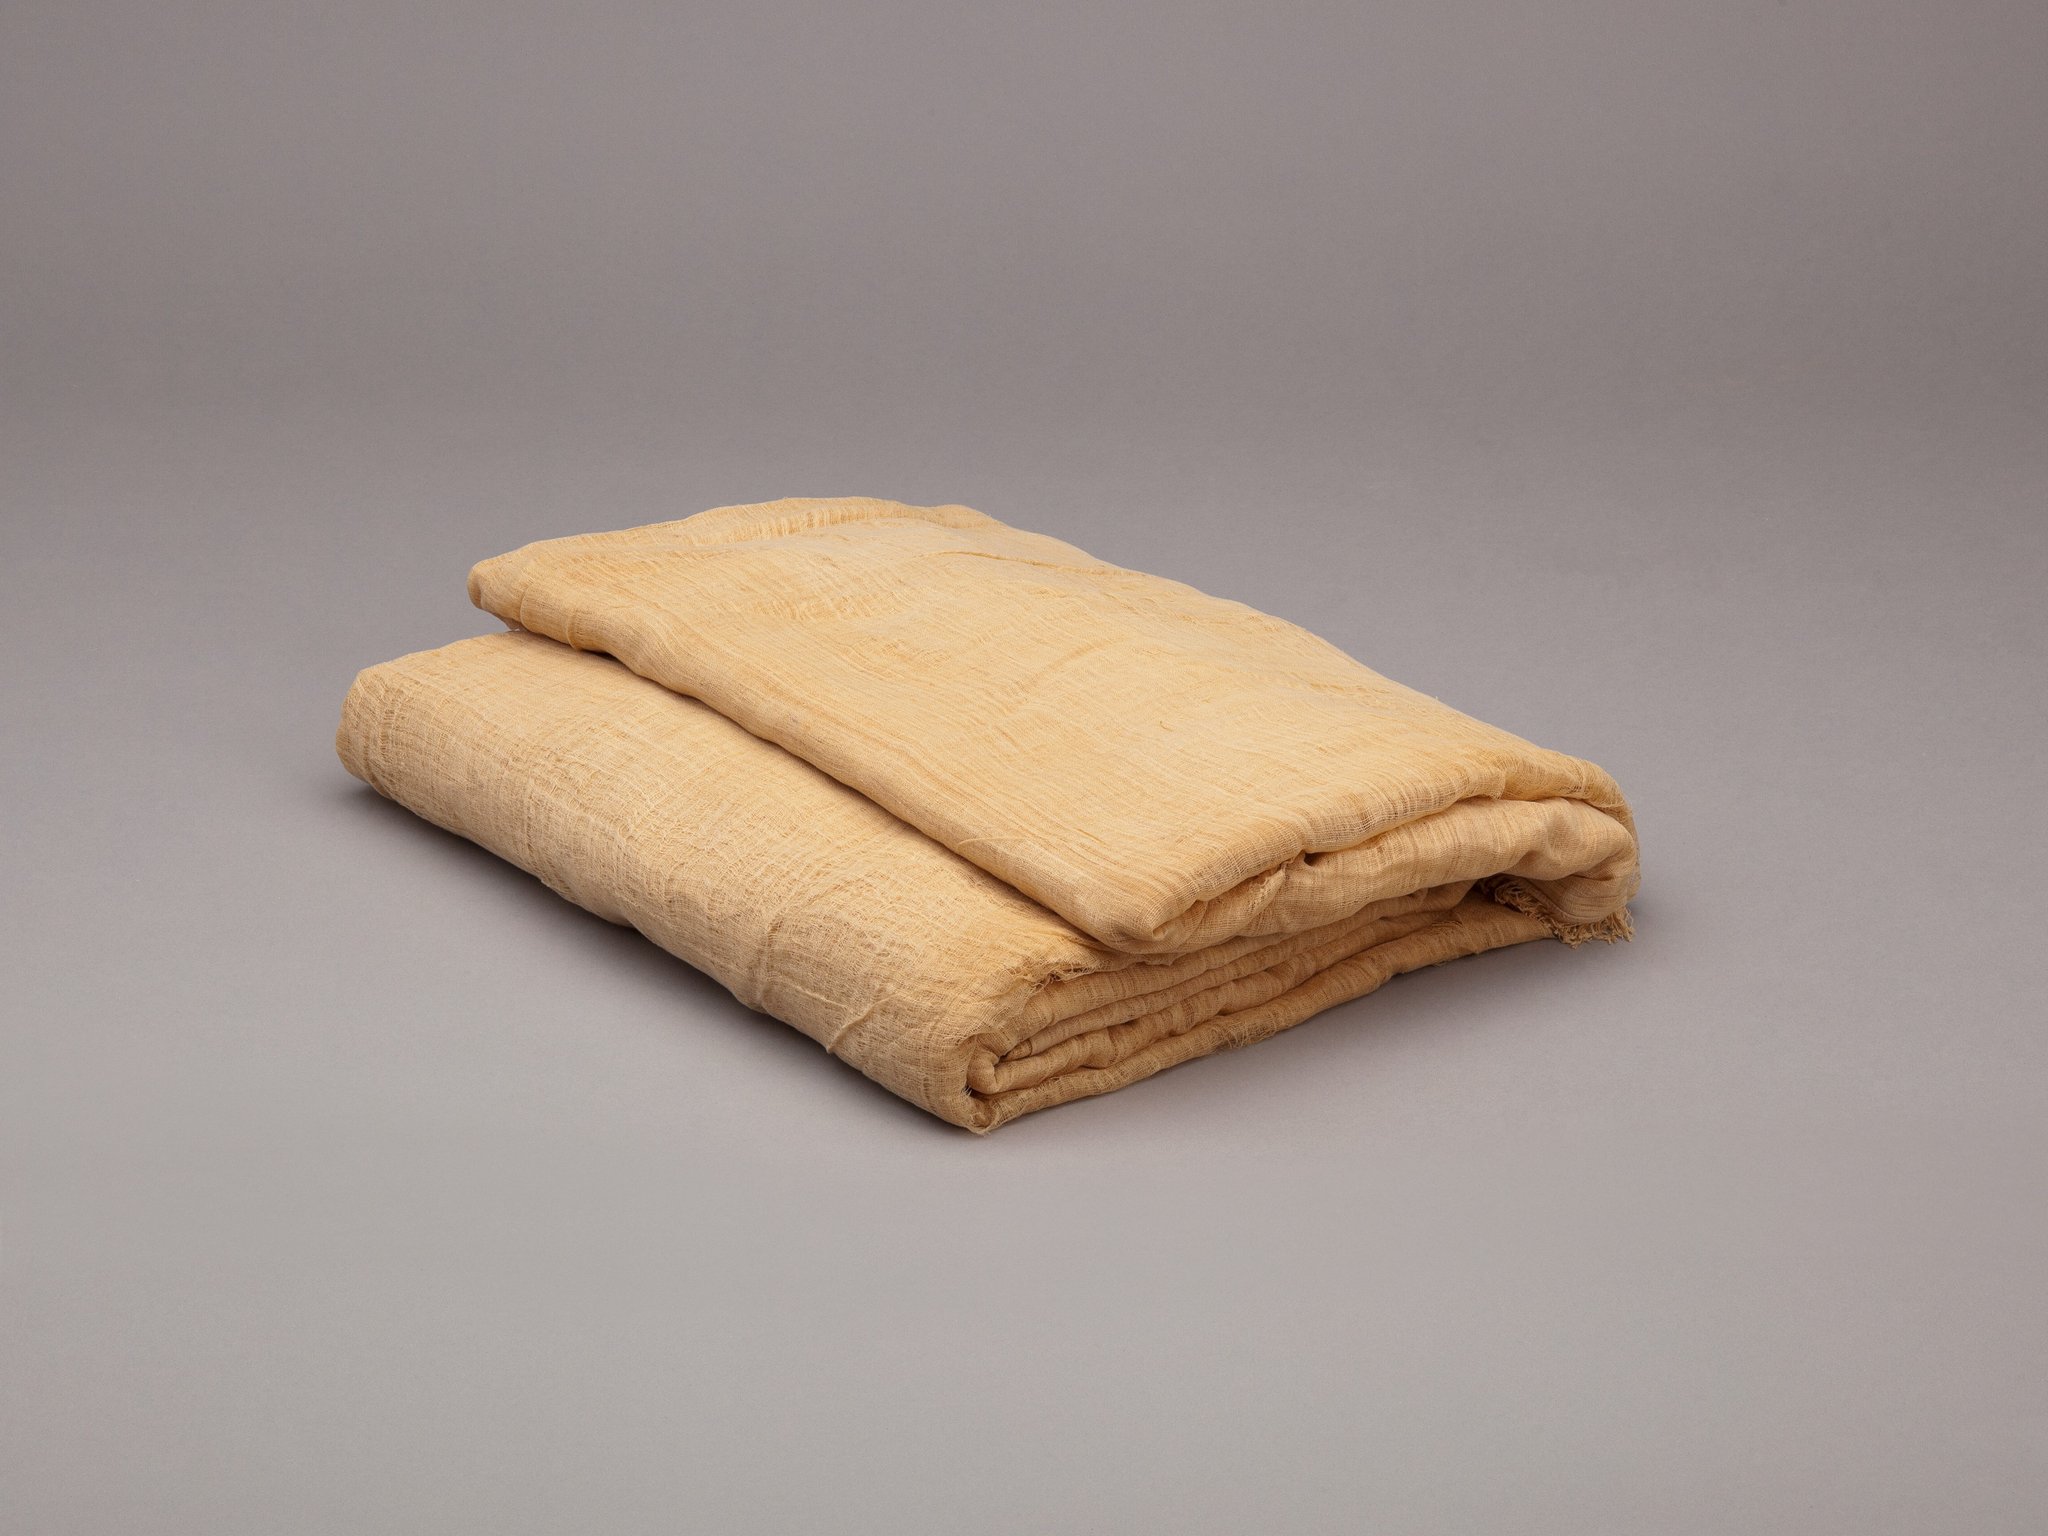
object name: linen mark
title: Sheet, linen mark, fine spin, irregular weave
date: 1492-1473 BCE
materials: linen, wax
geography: egypt